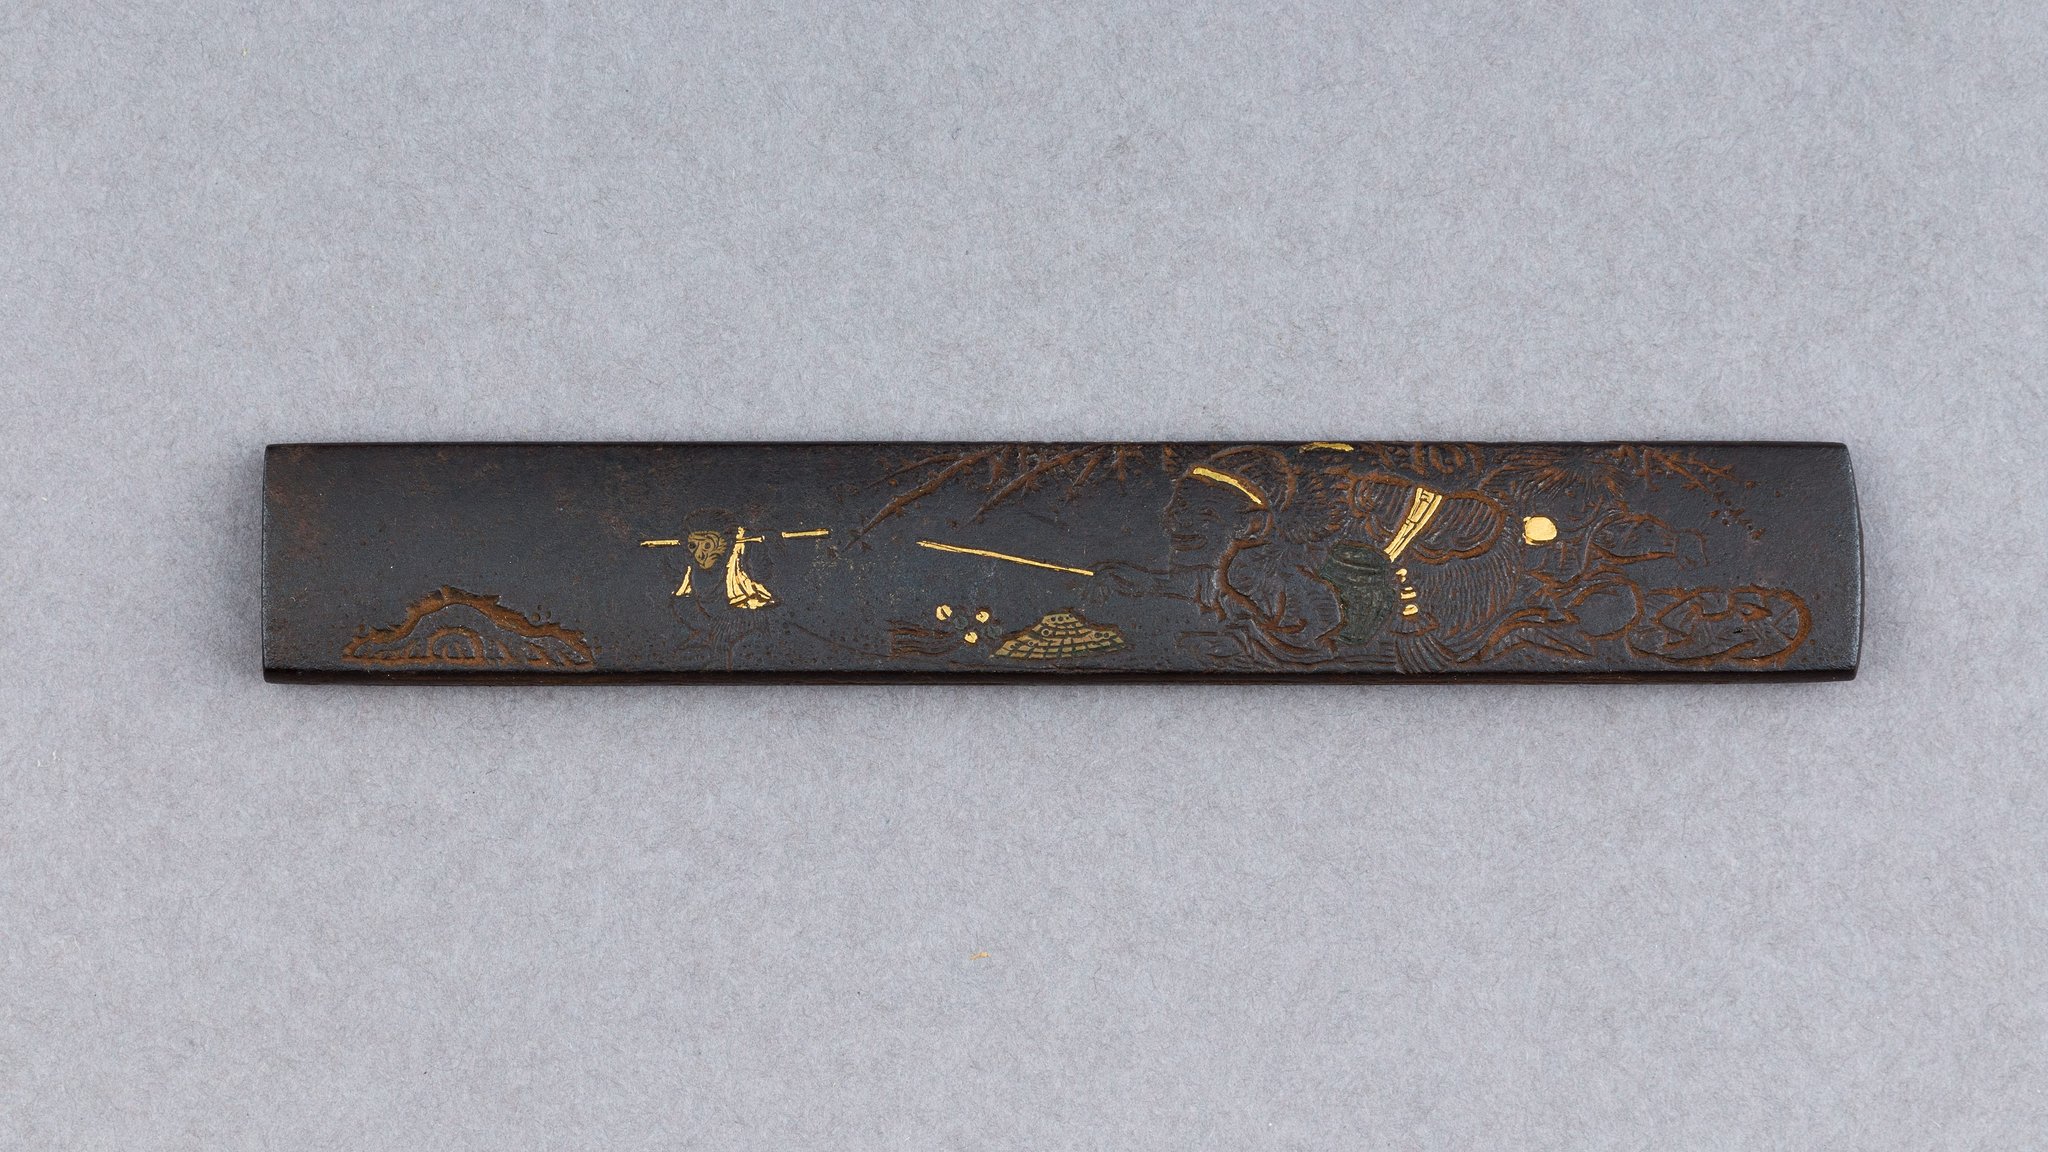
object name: knife handle kozuka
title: Knife Handle (Kozuka)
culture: japanese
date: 1615-1868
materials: gold, iron, silver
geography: japan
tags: men,monkeys